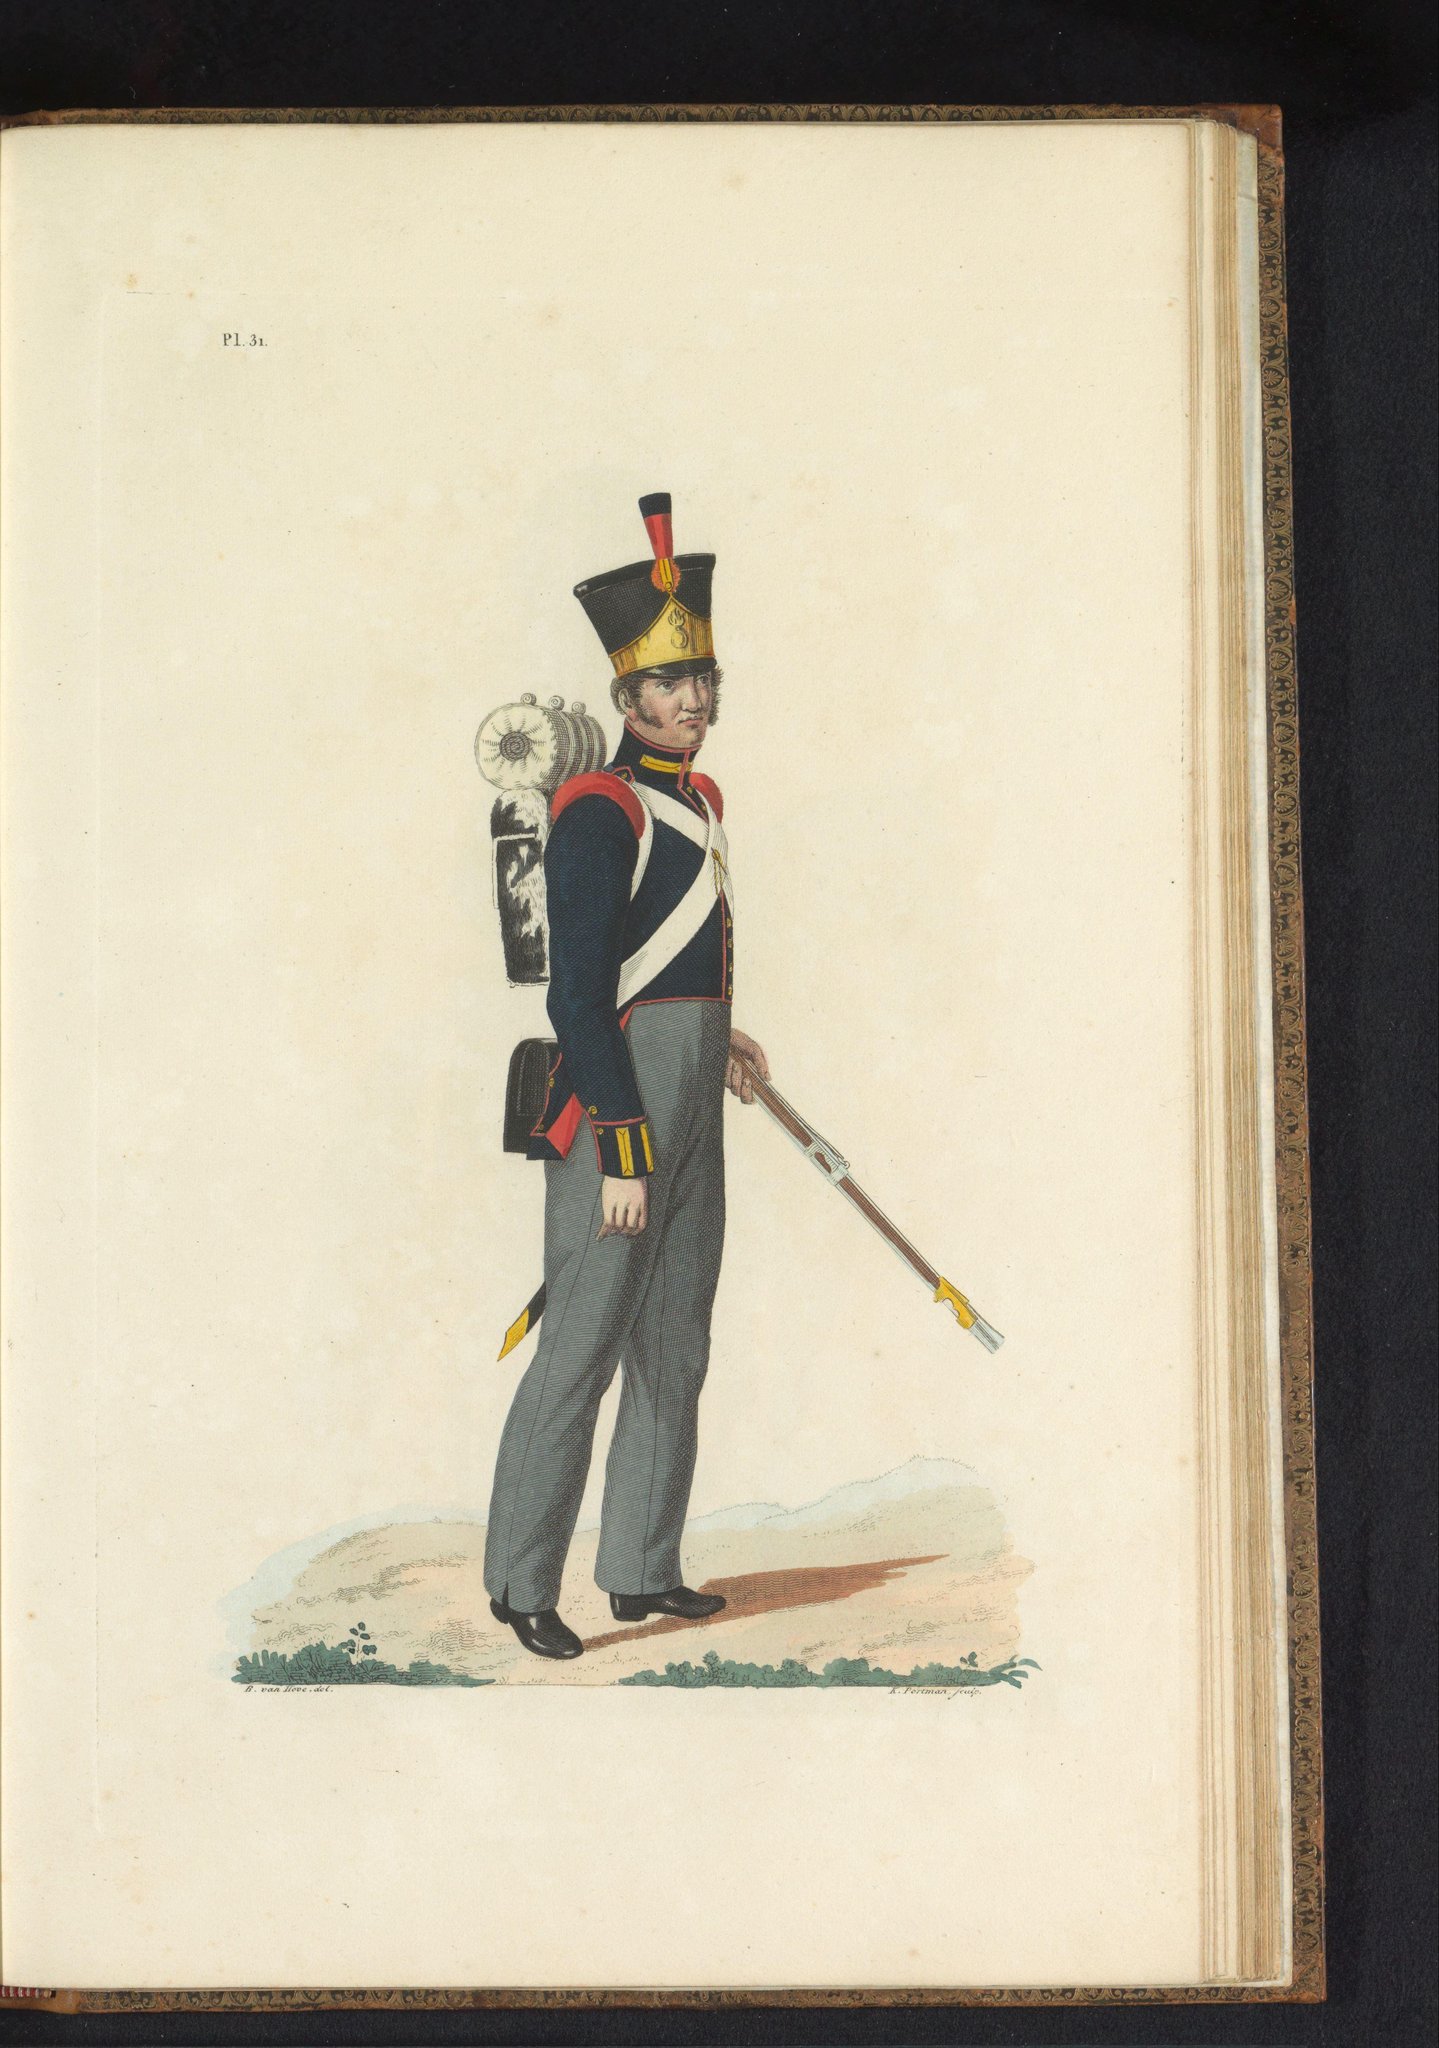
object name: print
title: Mineur of Sappeur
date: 1823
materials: paper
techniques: engraving, etching, hand coloring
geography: the hague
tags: (military) uniforms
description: Een Nederlandse mineur of sappeur van de artillerie. Plaat 31. Uniformvoorstelling in 'Beschrijving hoedanig de Koninklijke Nederlandsche troepen' van J.F. Teupken, 1823.